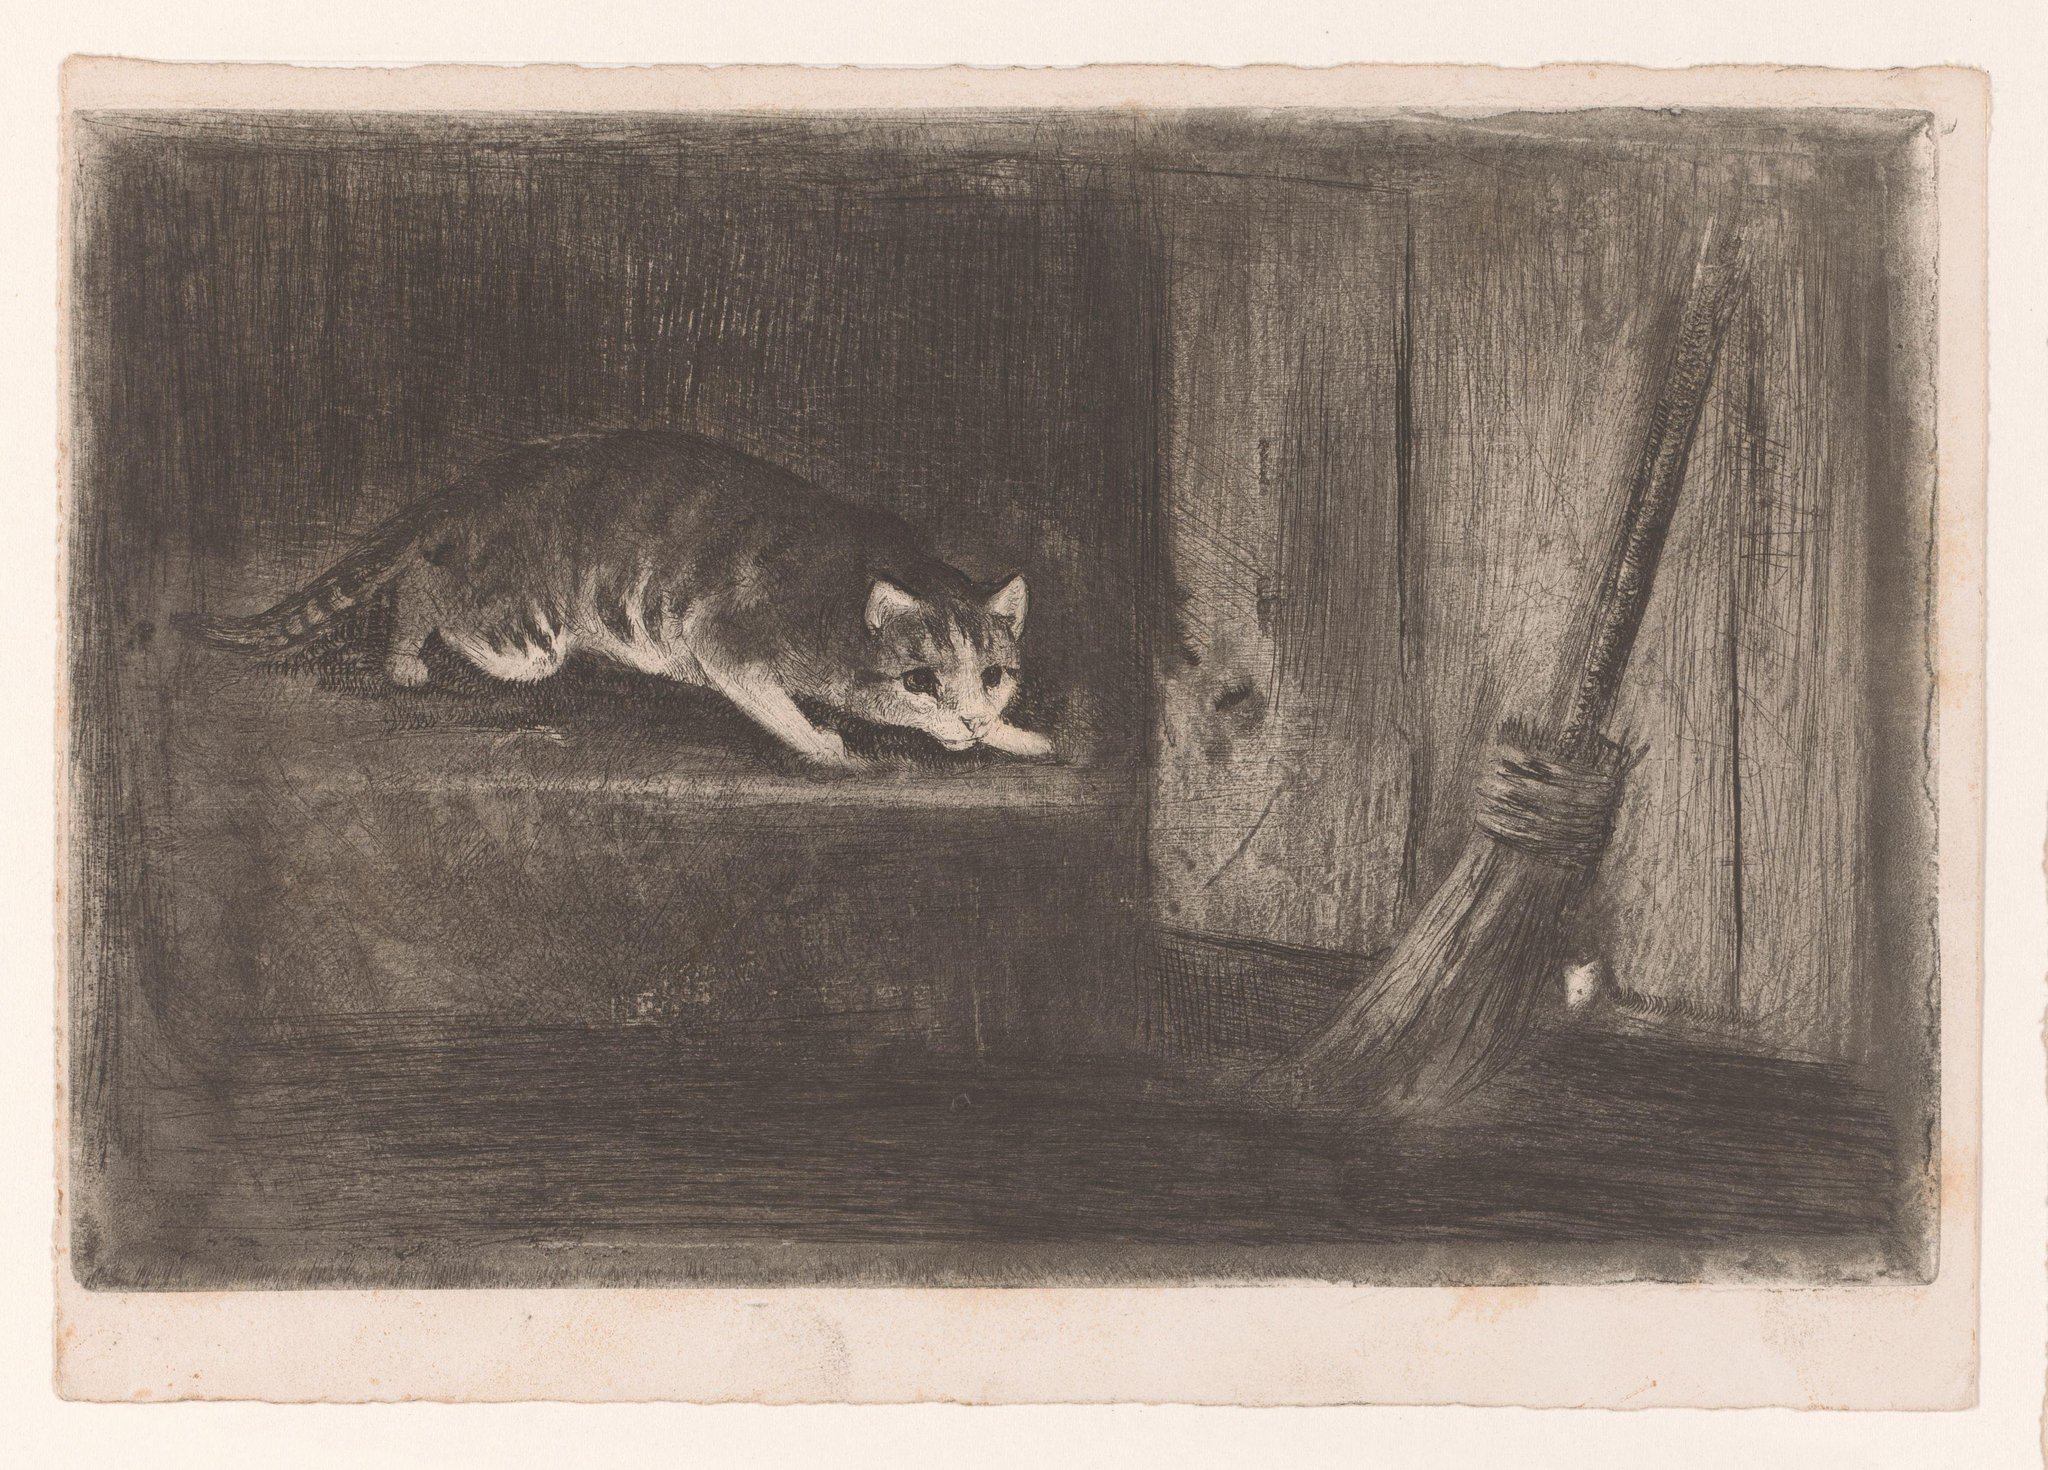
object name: print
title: Kat en muis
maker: charles verlat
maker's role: painter, print maker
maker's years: 1824-1890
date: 1834-1890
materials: paper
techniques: etching, intaglio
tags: cat and mouse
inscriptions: collector's mark: Lugt 2228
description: Kat besluipt een muis, die zich achter een bezem verbergt.